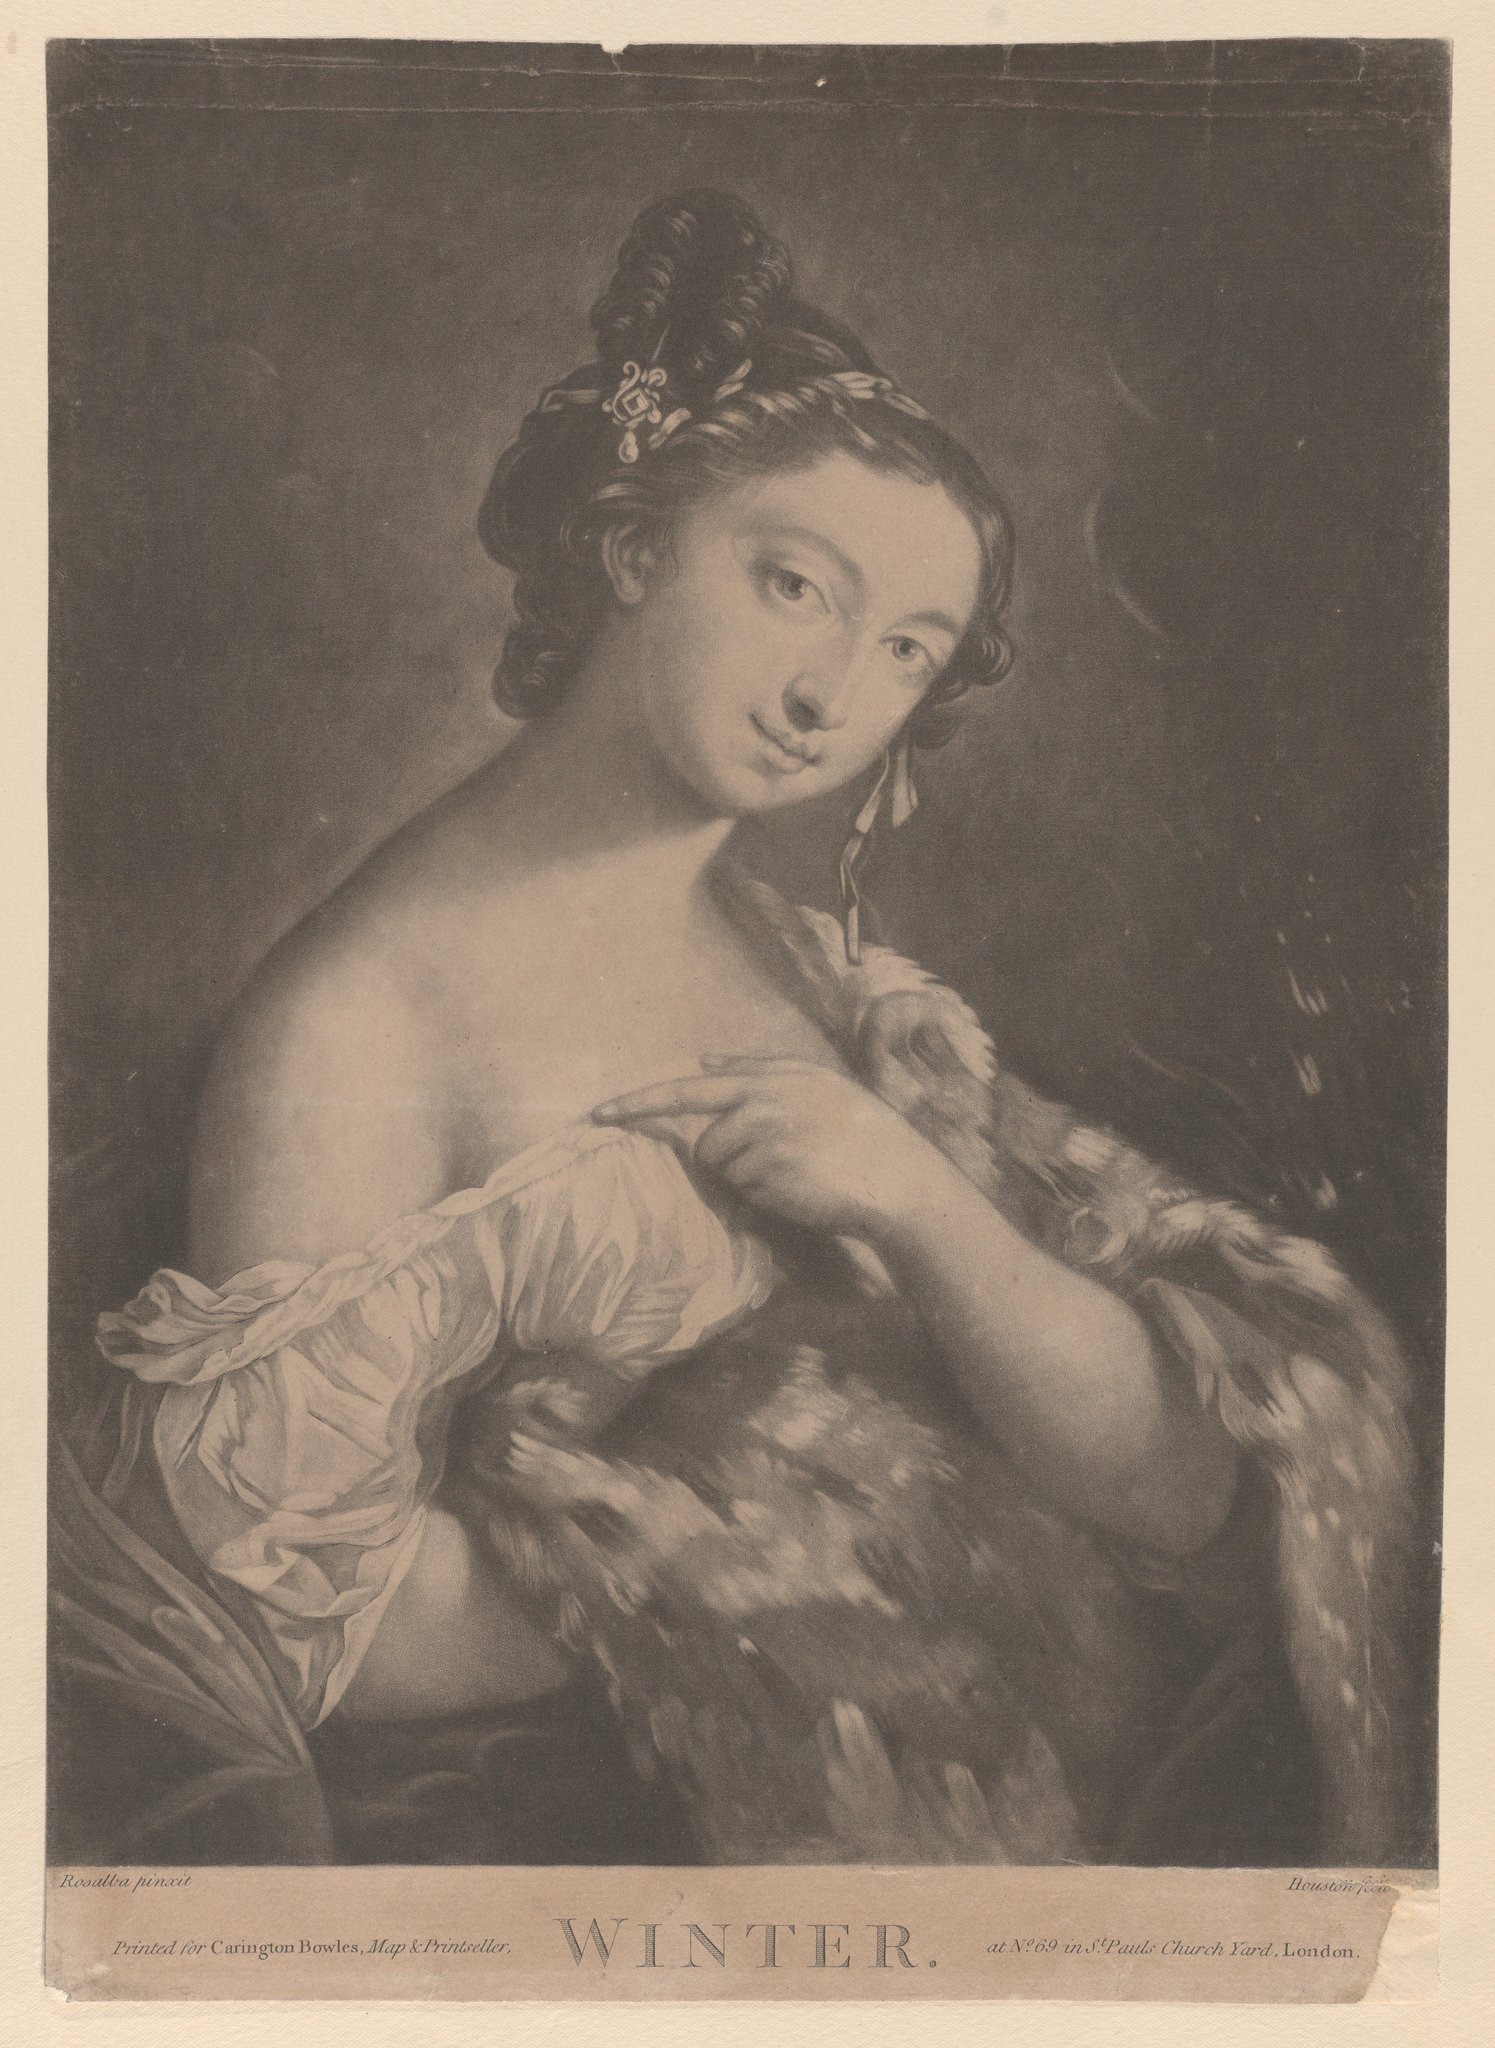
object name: print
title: Winter: a woman holding a spotted fur mantle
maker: richard houston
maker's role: artist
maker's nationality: irish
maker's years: 1721-1775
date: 1775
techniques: mezzotint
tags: women